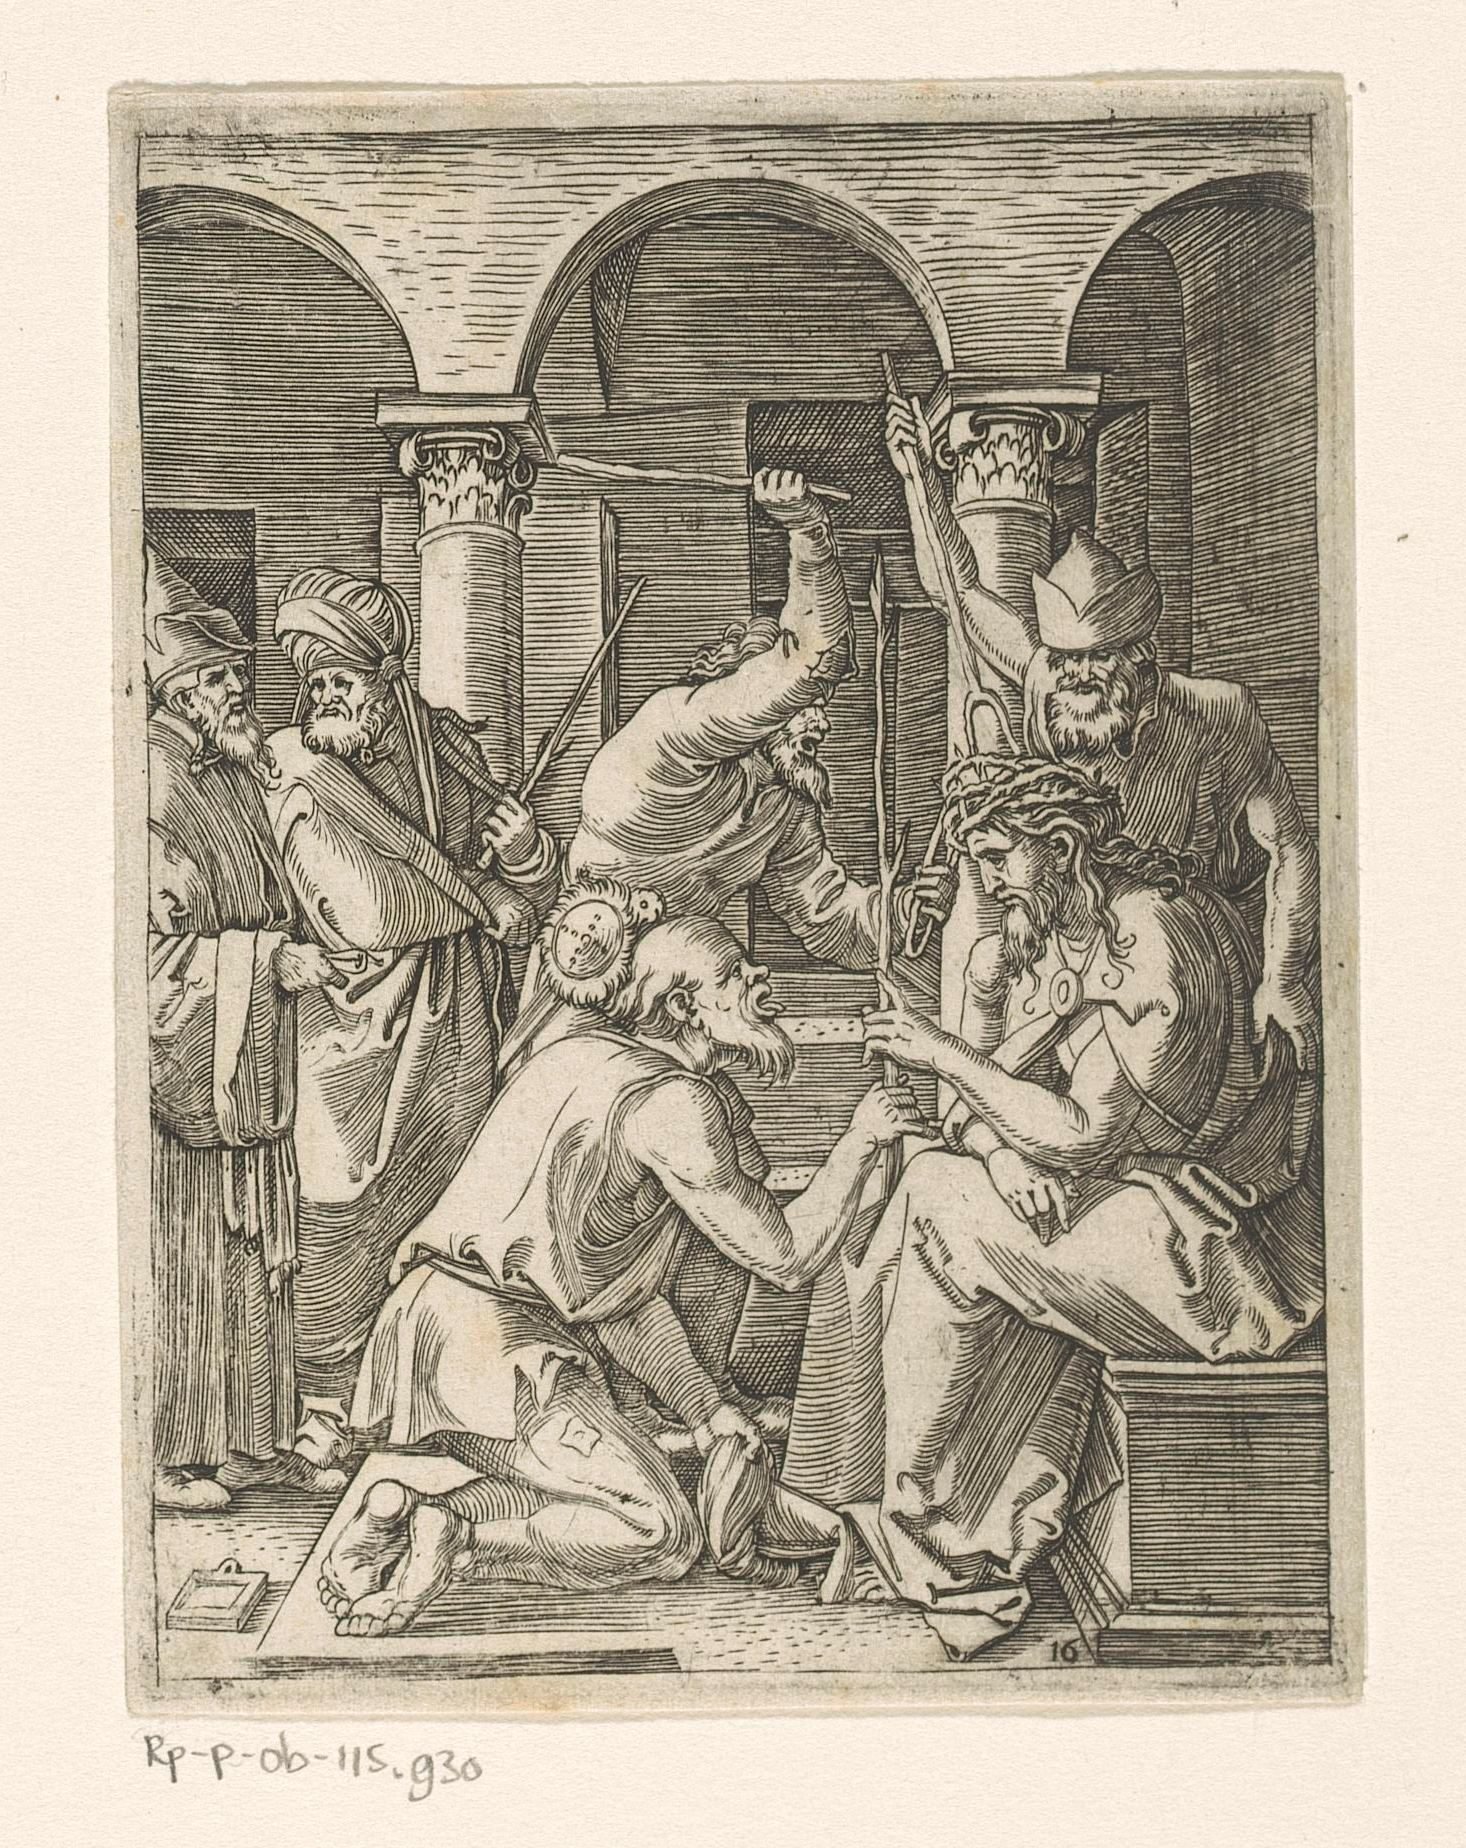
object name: print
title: Doornenkroning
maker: marcantonio raimondi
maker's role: print maker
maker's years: 1470-1534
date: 1511-1534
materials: paper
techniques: engraving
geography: germany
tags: the crowning with thorns: soldiers with sticks place a thorny crown on christ's head and give him a reed (matthew 27:27-31; mark 15:16-20; john 19:2-3)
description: Prent naar houtsnede van Albrecht Dürer uit een serie van zevenendertig prenten met als onderwerp het levensverhaal van Christus, bekend als Passie van Christus.